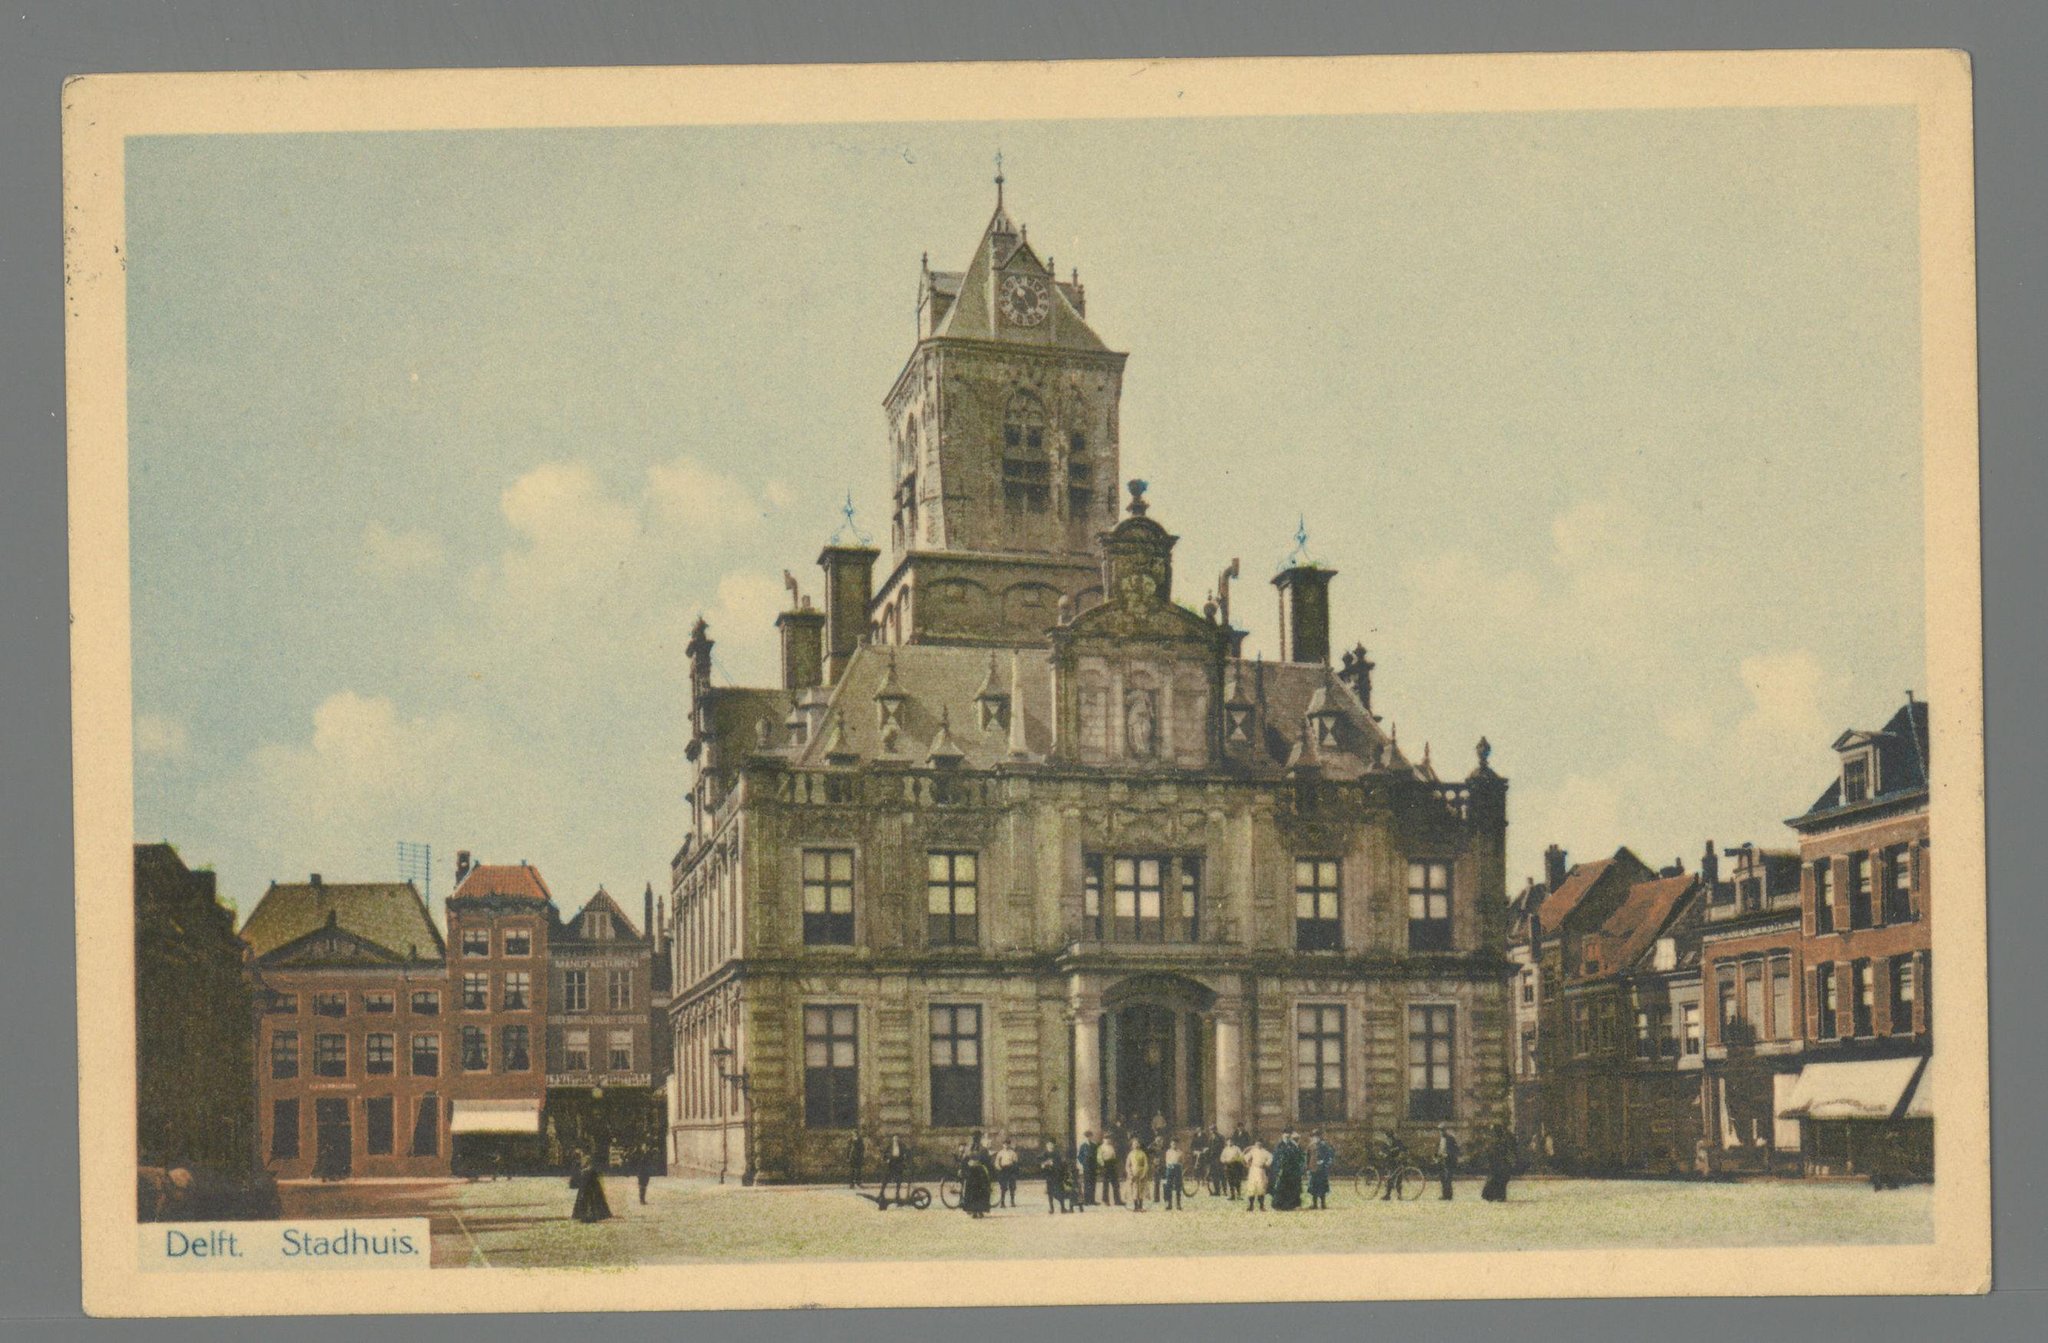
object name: photomechanical print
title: Delft. Stadhuis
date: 1911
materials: cardboard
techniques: collotype process, lithograph, writing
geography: delft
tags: townhall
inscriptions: postage stamp